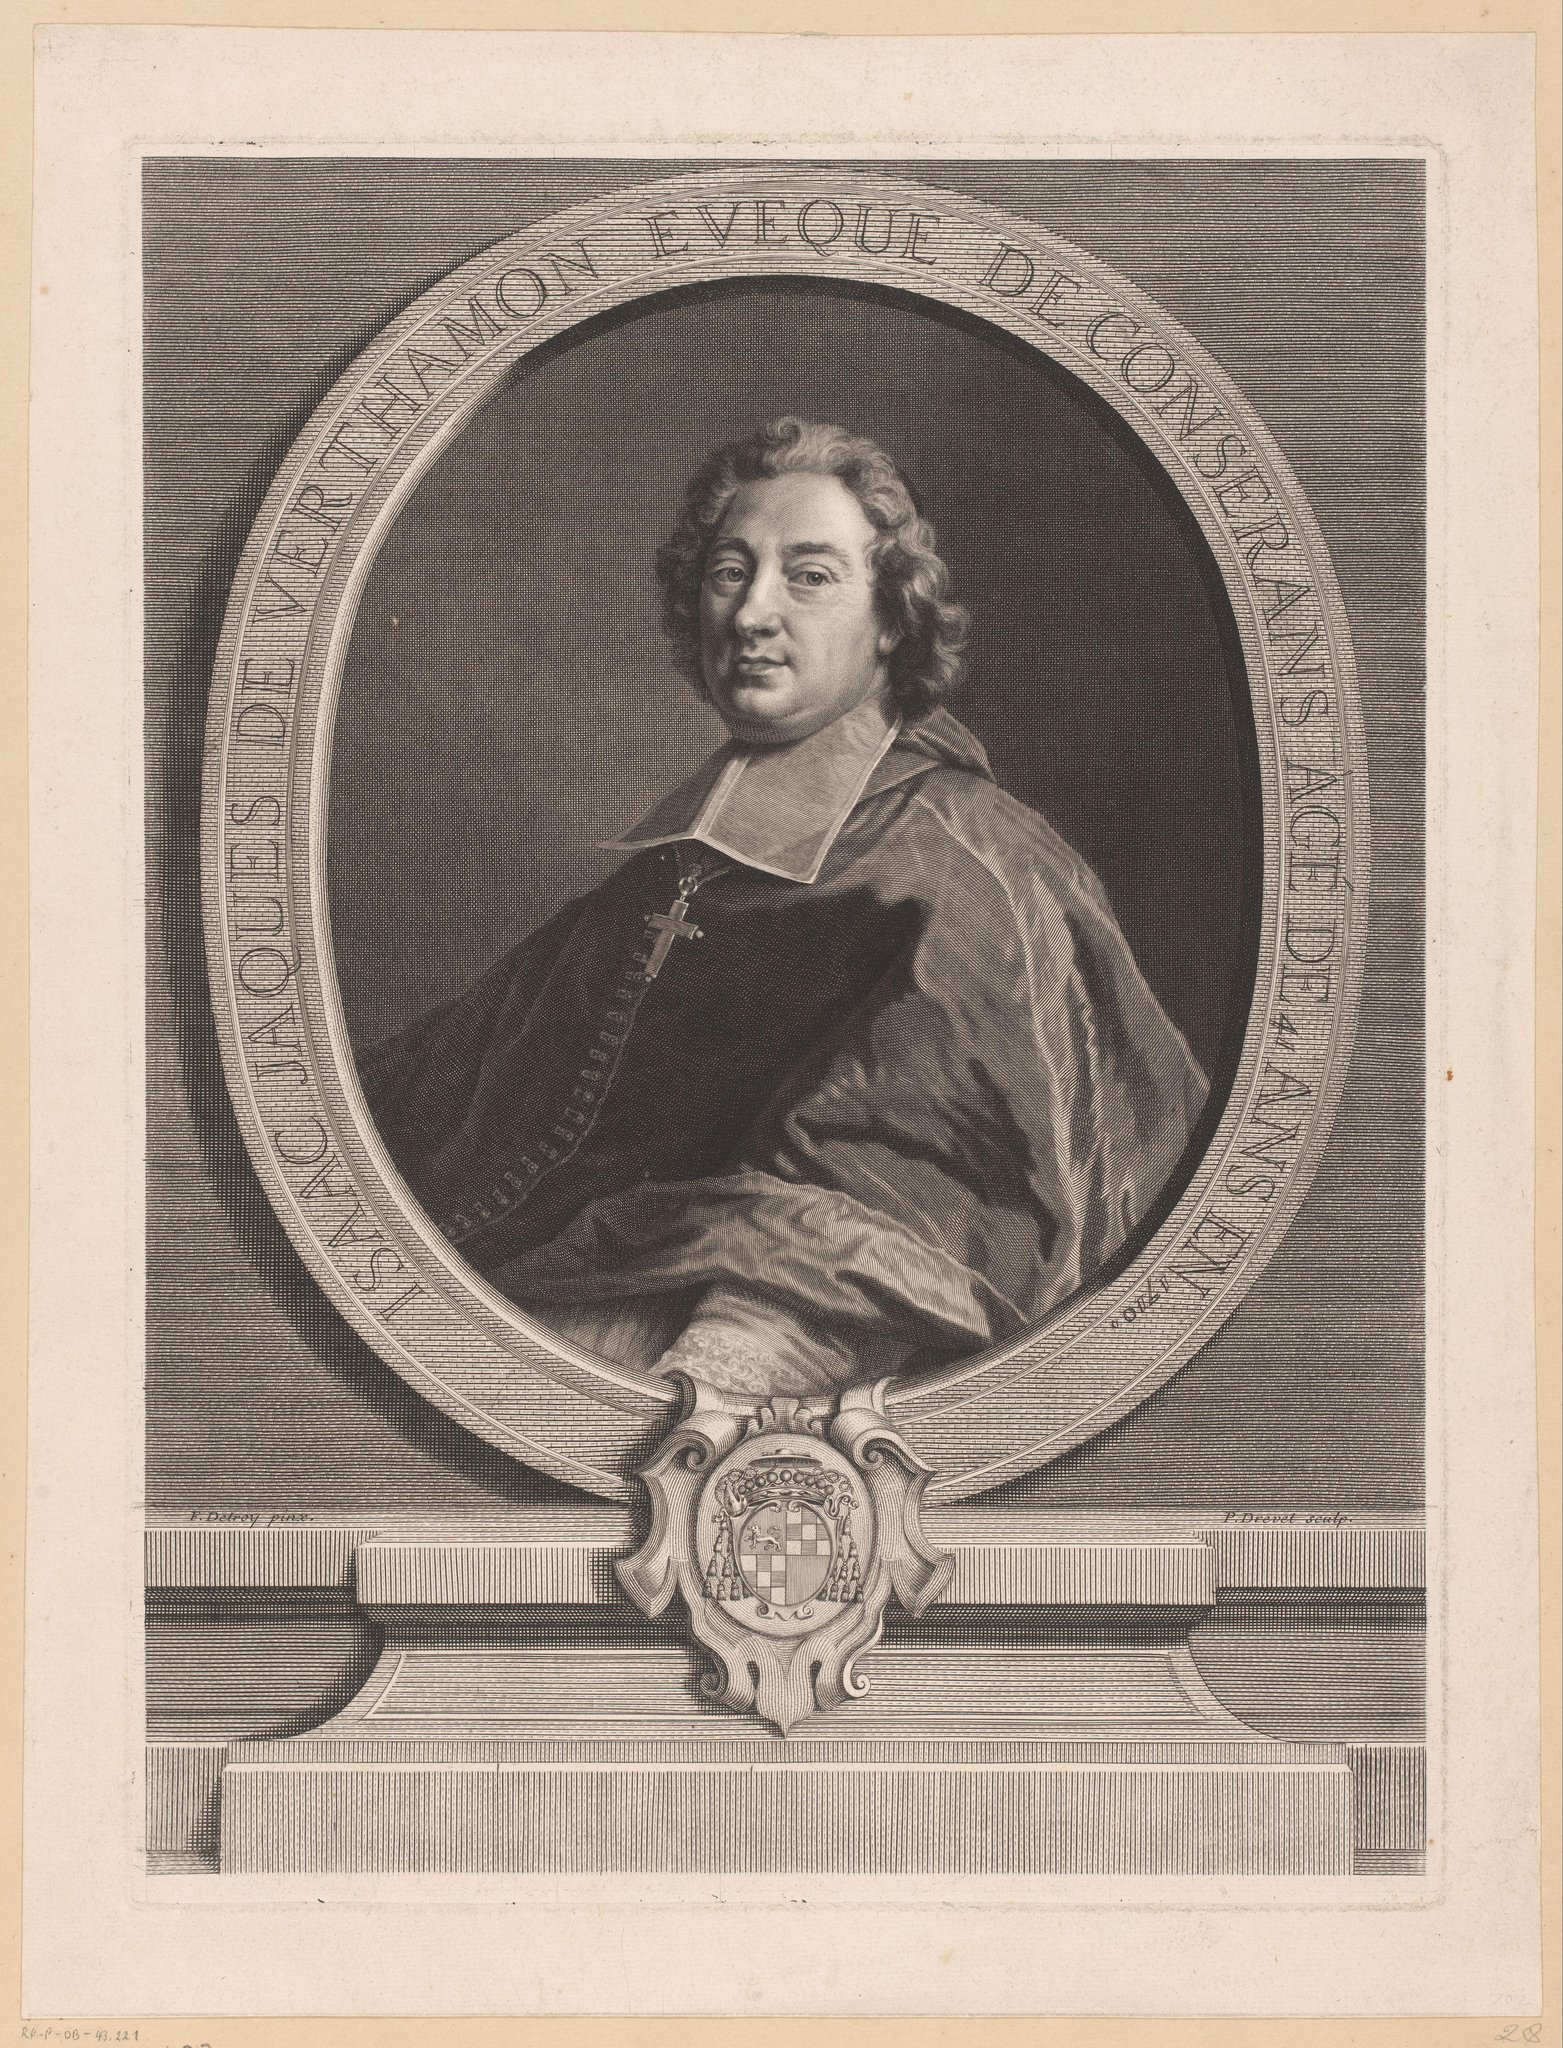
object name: print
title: Portret van Isaac-Jacques de Verthamon de Chalucet op 41-jarige leeftijd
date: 1710-1725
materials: paper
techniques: engraving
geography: france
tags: ornament ~ medallion, historical persons, armorial bearing, heraldry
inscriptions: collector's mark: Lugt 240